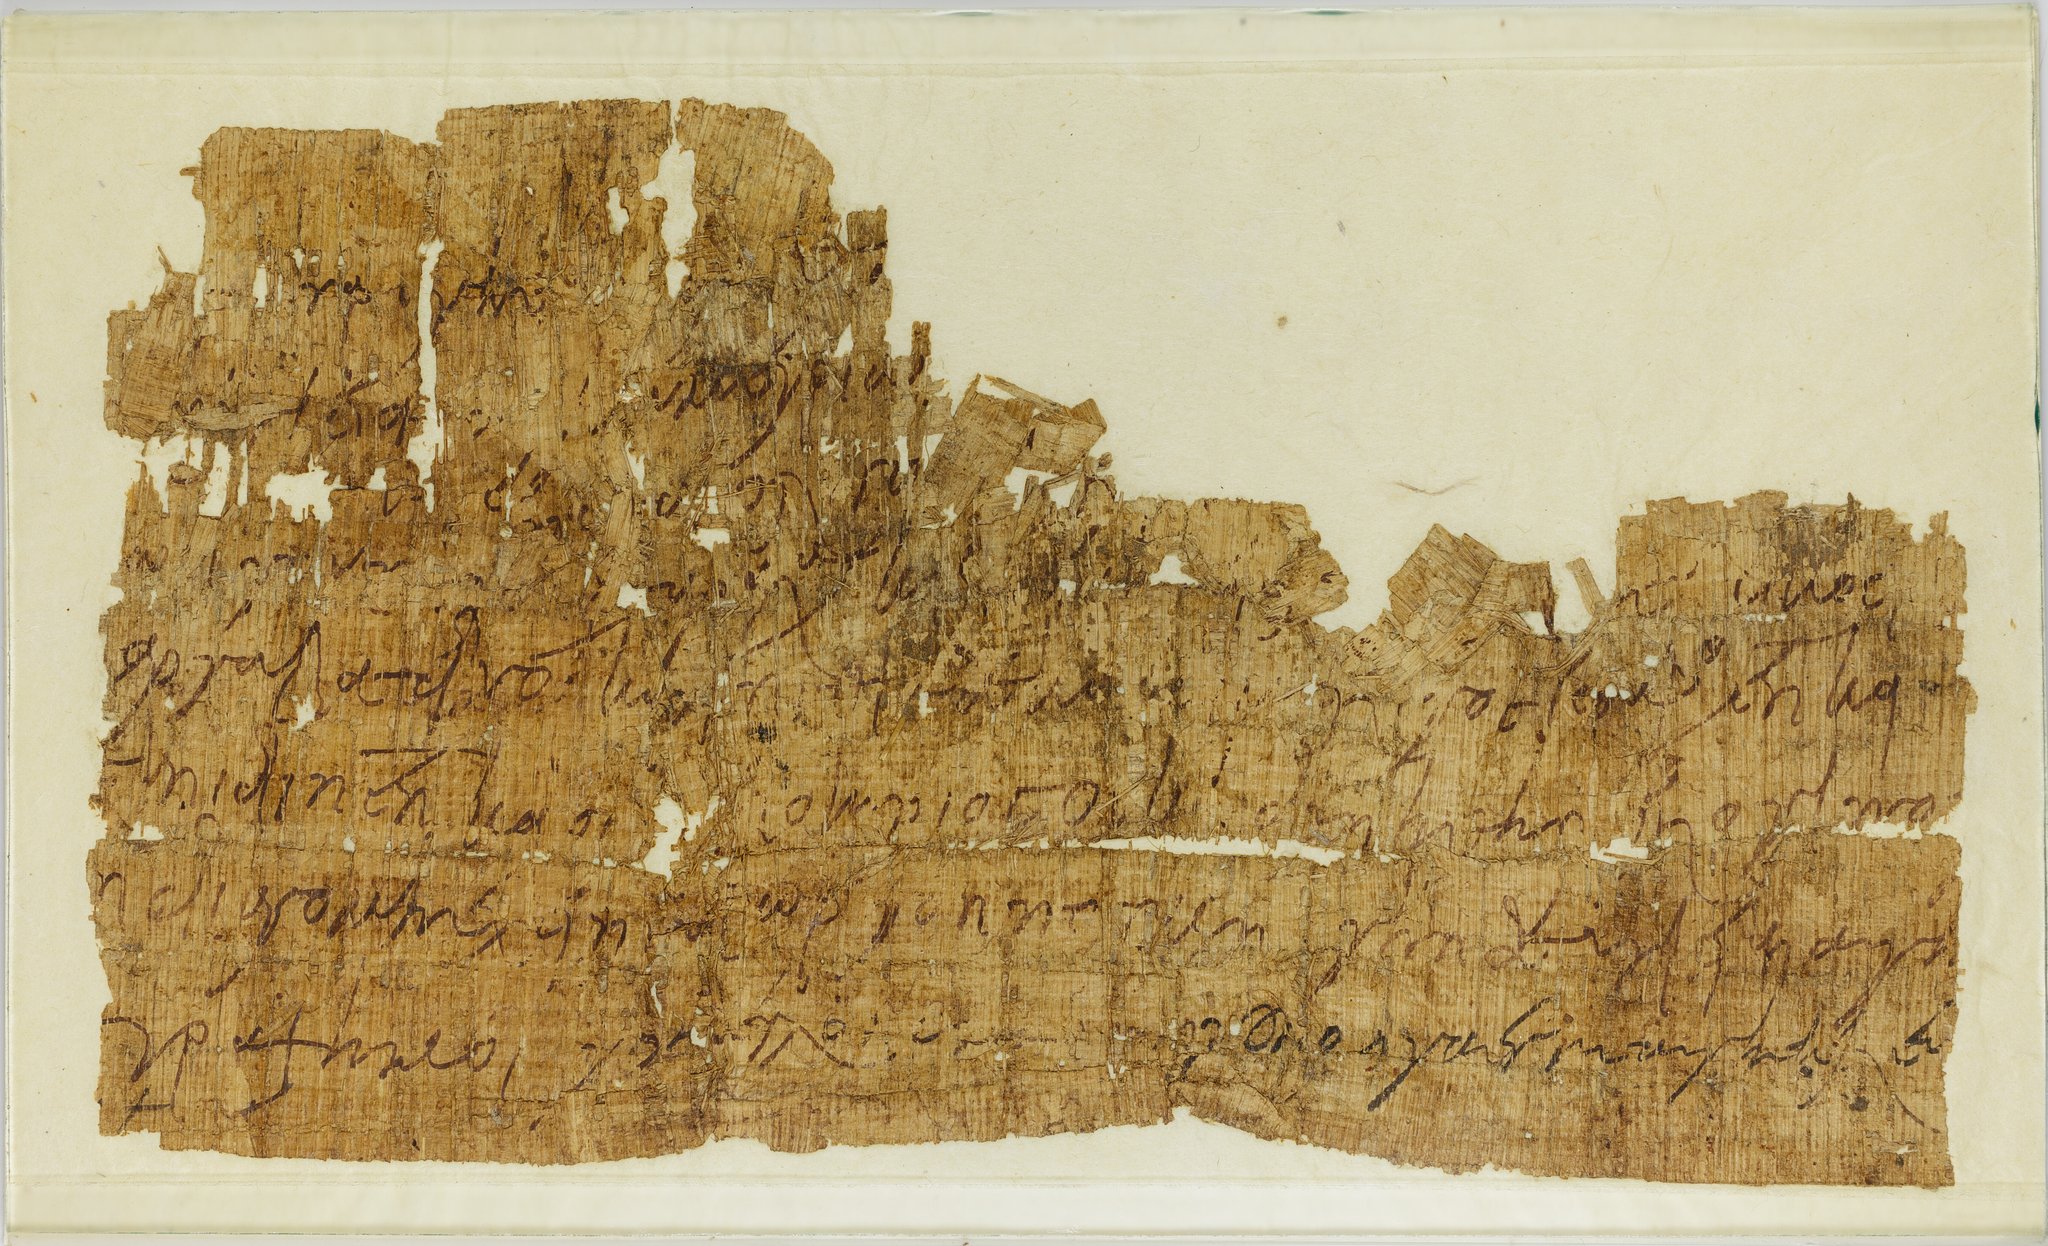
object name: papyrus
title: Papyrus fragment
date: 301-400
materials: ink, papyrus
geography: egypt